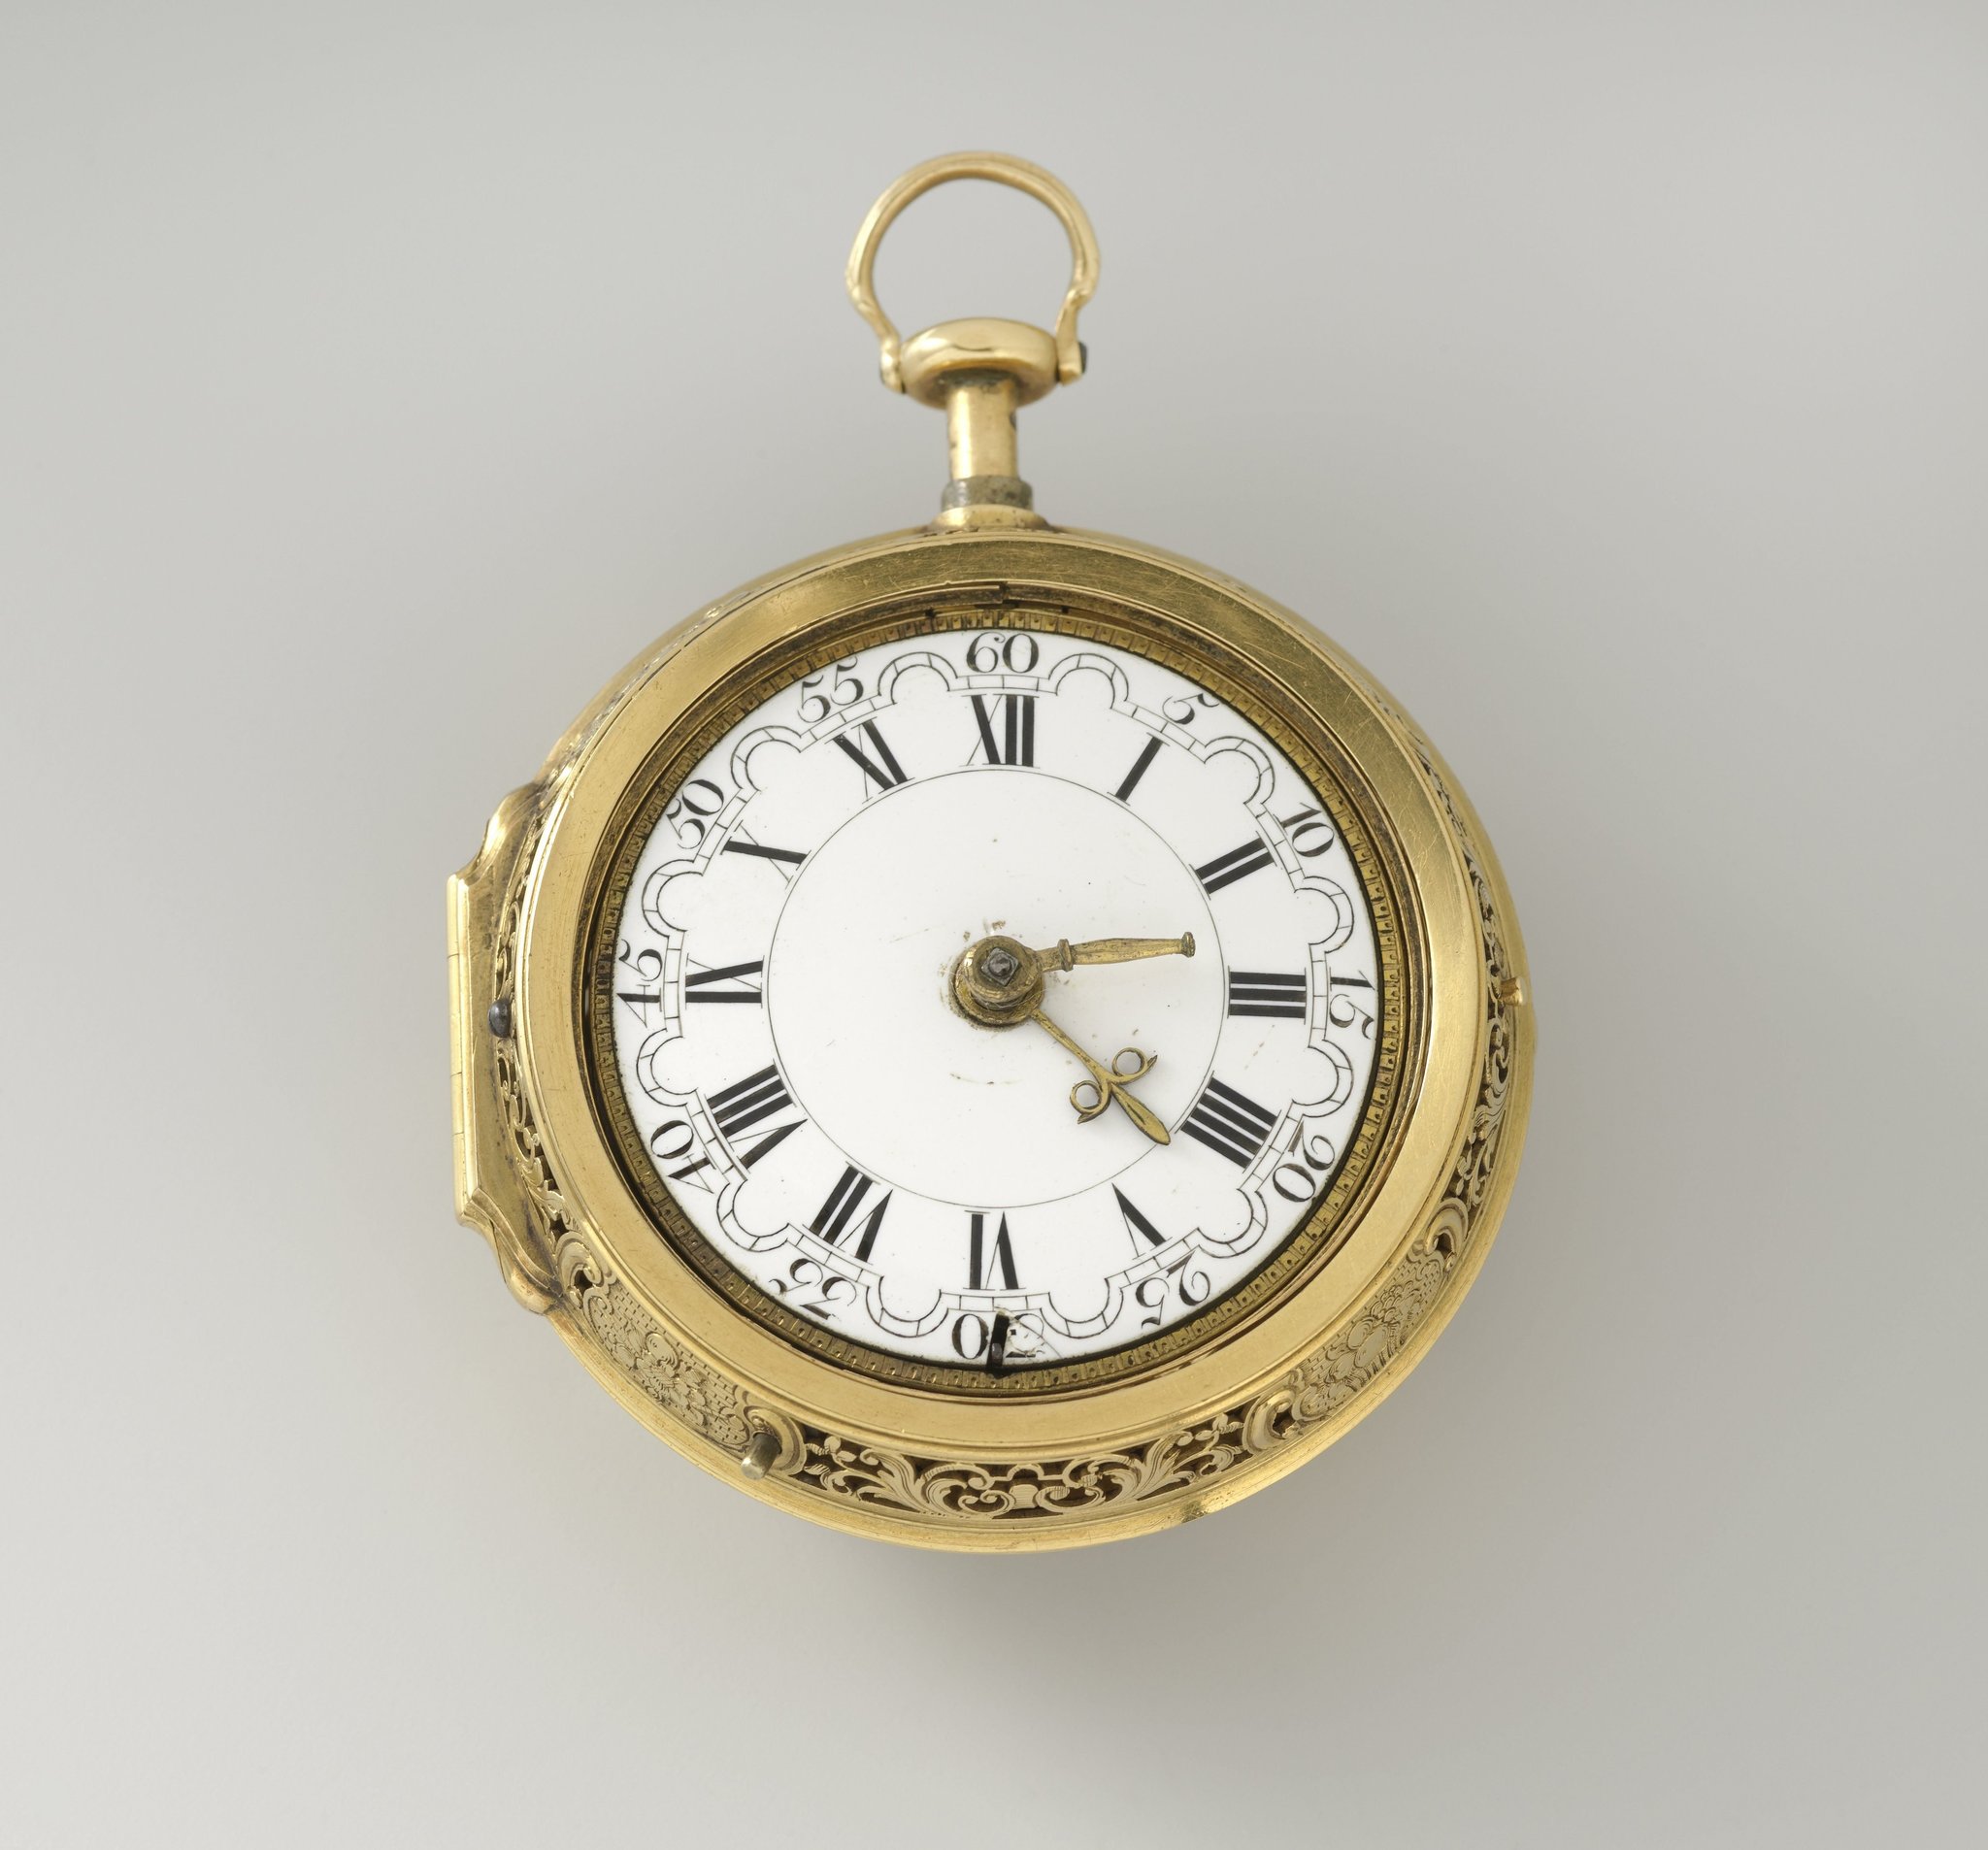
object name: pocket watch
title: Dumb Repeating Watch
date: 1728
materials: glass, gold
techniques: repoussé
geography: amsterdam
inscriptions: date letter: ‘S’, signature: ‘ANDRIES // VERMEULEN // AMSTERDAM’, signature: ‘ANDRIES VERMEULEN AMSTERDAM // 673’, maker's mark, duty mark, alloy mark, town mark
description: De horlogekast bestaat uit een binnenkast en een overkast. De bovenzijde van de bak van de ronde, bolle scharnierende overkast is deels geciseleerd, deels gegraveerd met een symmetrisch, geschubd veld met een ovaal, glad medaillon, omlijst door bladranken en C-voluten met hermen aan de zijden, een gebaard masker aan de bovenzijde en een meisjesportet aan de onderzijde. Het veld is geplaatst op een geponste grond. De zijkant van de bak is versierd met vier schildvormige medaillons met gegraveerde voorstellingen van achtereenvolgens een putto met een bloemenmand, een putto met korenaren, een putto zittend op een ton met een drinkschaaltje in de hand en een putto zittend bij een stoof, respectievelijk de lente, de zomer, de herfst en de winter voorstellend. Hiertussen bevinden zich symmetrische, opengewerkte motieven van bloemranken, omkaderd door geprofileerde C-voluten. Tegenover het scharnier bevindt zich de bolvormige drukker waarmee de overkast geopend kan worden. De bak heeft een geprofileerde, uitstekende bovenrand waarin een halfronde opening voor dependant is uitgespaard. Hierop sluit met zo'n zelfde rand de scharnierende sluitring, waarin eveneend een halfronde opening is uitgespaard. De sluitring is opengewerkt en gegraveerd met vier symmetrische motieven van bladranken, die corresponderen met opengewerkte versieringen van de zijkant van de bak. Ze zijn afgewisseld met door staande C-voluten begrensde velden met gegraveerde voorstellingen van respectievelijk een aan linten opgehangen vruchtentros, een mand met vruchten, een aan linten opgehangen bloemenslinger en een bloemenmand, alle tegen een achtergrond van bakstenen en corresponderend met de voorstellingen van de seizoenen. De ronde, bolle, scharnierende binnenkast is aan de zijkant opengewerkt en gegraveerd met een breed fries van symmetrisch geplaatste bloemrankenmet vogels. Het fries is onderbroken door een met C-vuloten omgeven veld, dat is gegraveerd met een motief van bakstenen en waarin de pendant met beugel is bevestigd. Op de tegenoverliggende zijde van het fries is een leeuwenkop gegraveerd. het fries is aan de bovenzijde begrensd door een smalle rand van een zich herhalend motief van punten en streepjes, en aan de onderzijde door een smalle rand van een zich herhalend motief van een schelp en twee voluutjes. De binnenkast heeft een scharnierende glasrand met lichtgewelfd horlogeglas. Aan de achterzijde bevindt zich het cirkelvormige opwindgat.